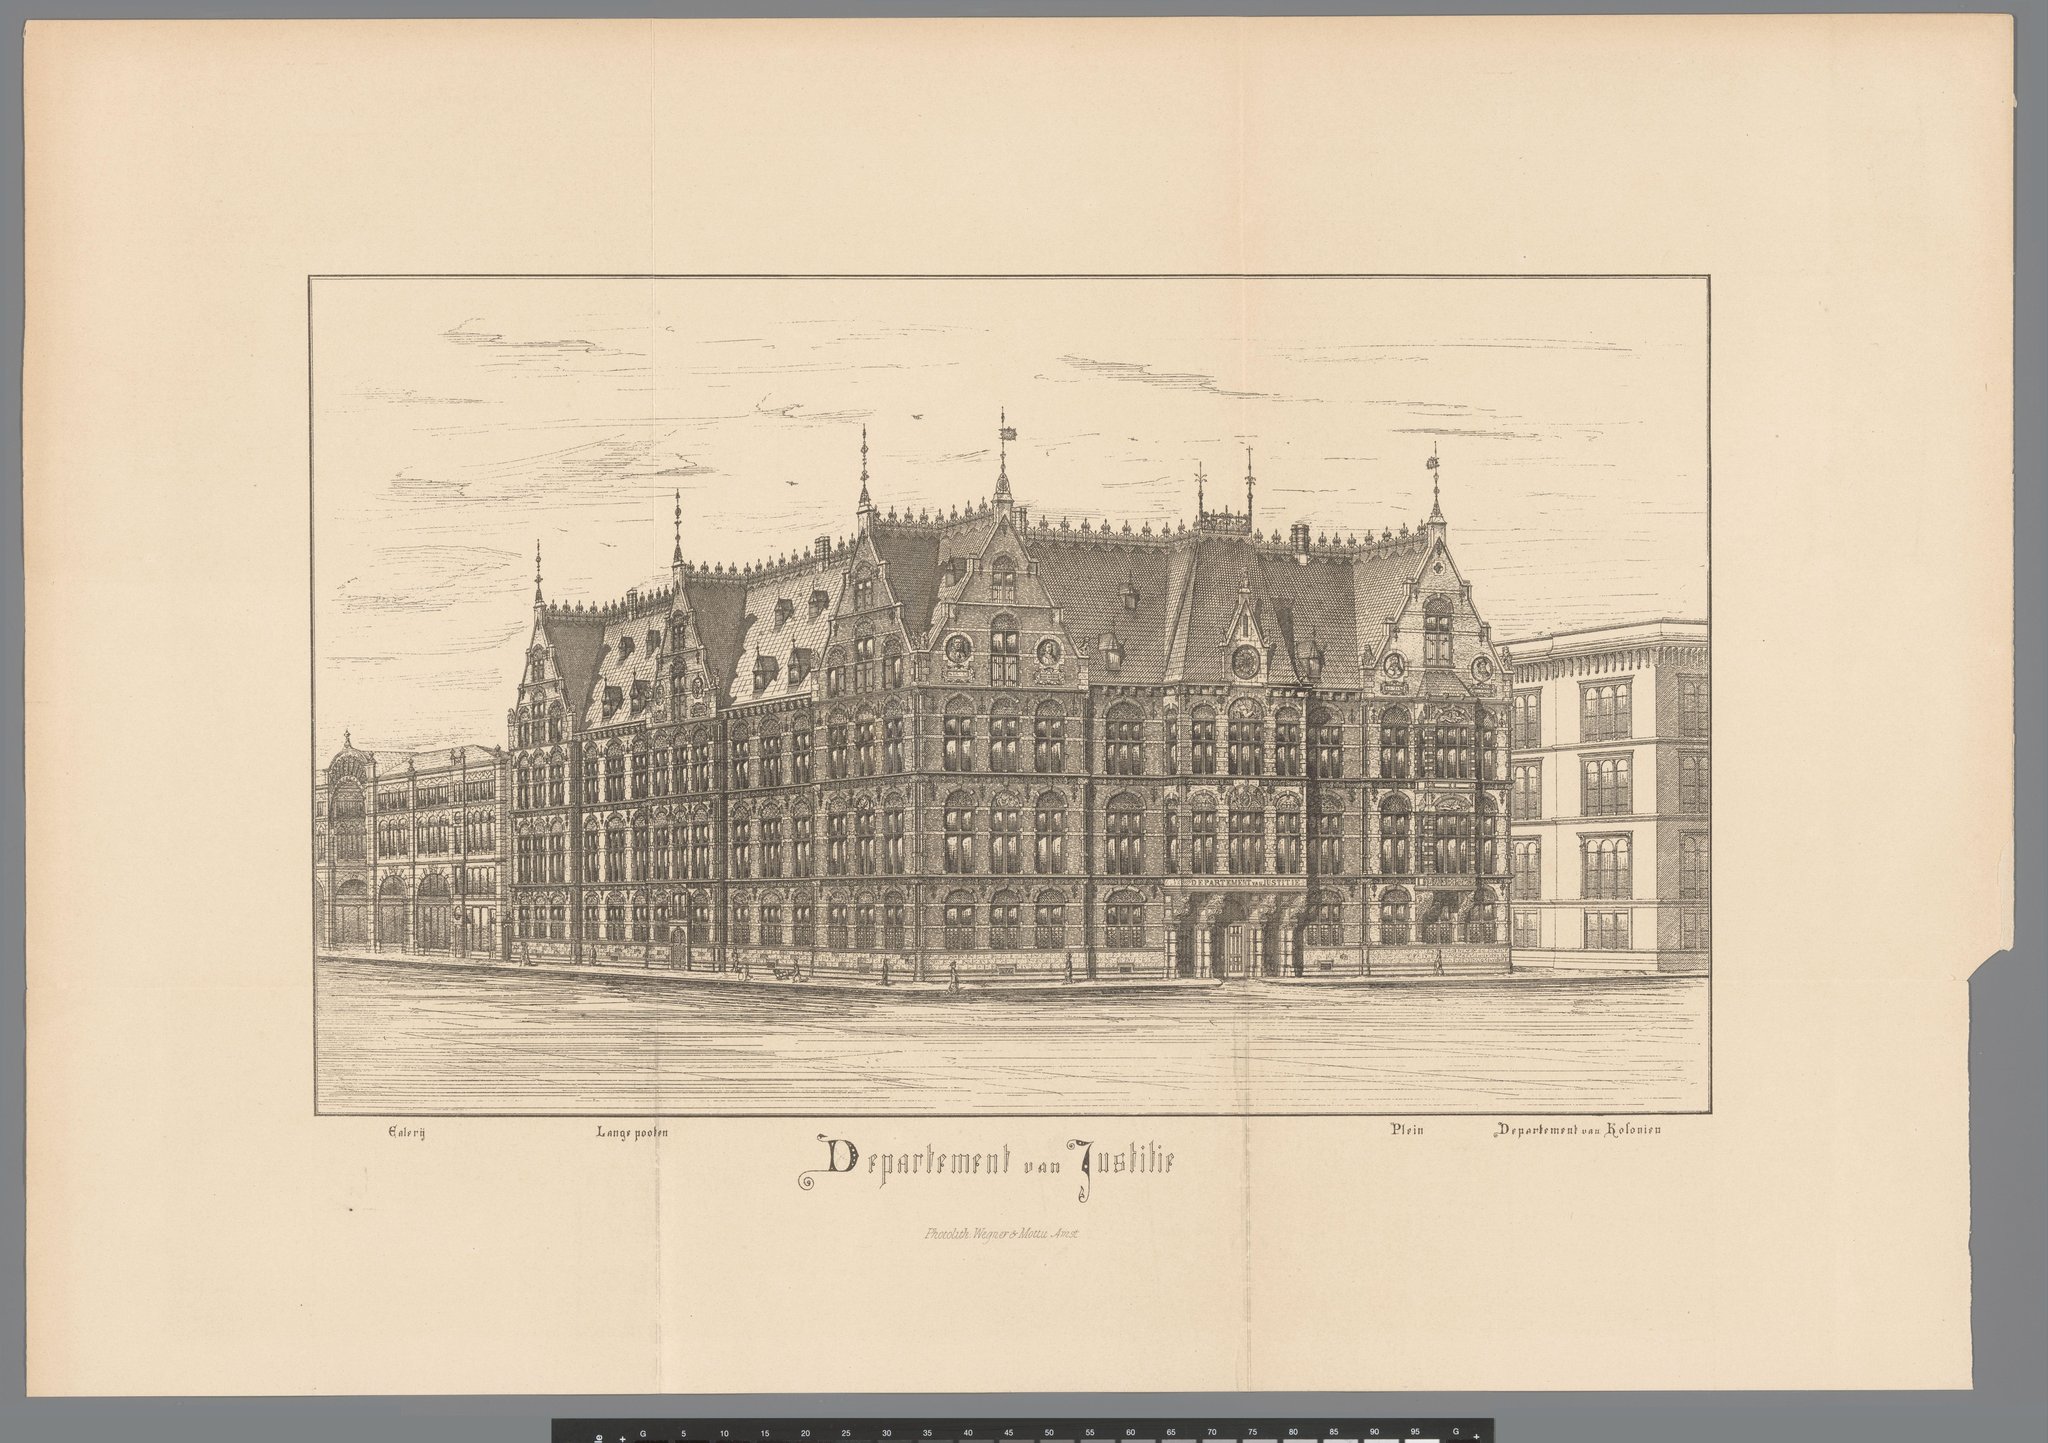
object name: photomechanical print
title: Departement van Justitie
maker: willem cornelis de graaff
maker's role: publisher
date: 1881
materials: paper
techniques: photolithography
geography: haarlem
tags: square, place, circus, etc., court building, the hague